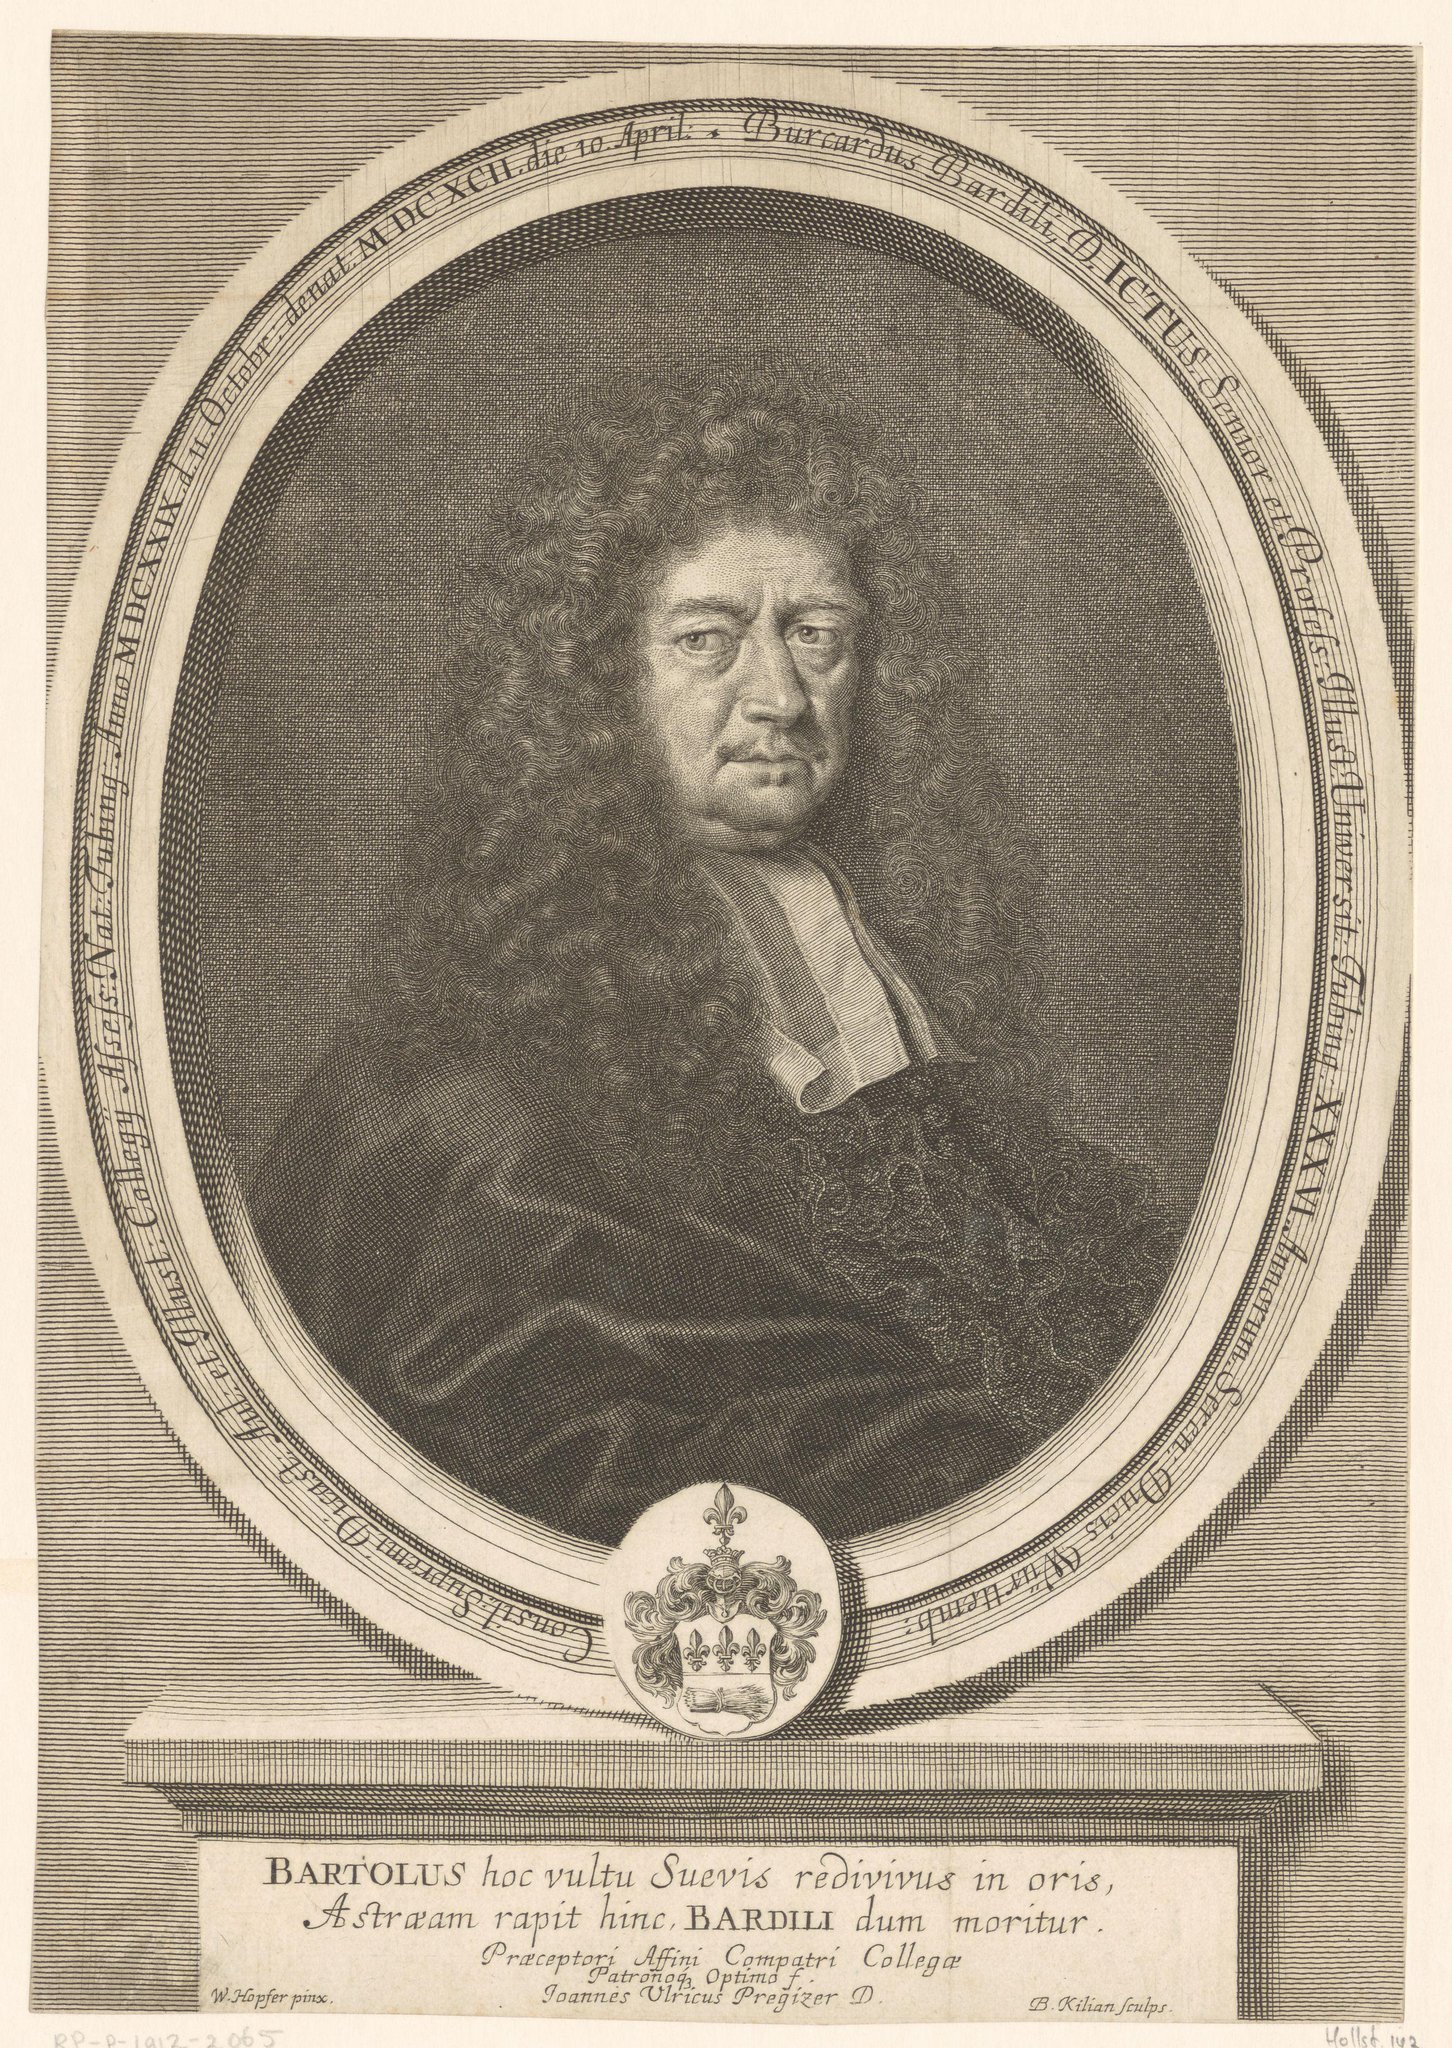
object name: print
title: Portret van Burckhard Bardili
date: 1692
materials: paper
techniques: engraving, etching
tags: further education (+ portrait of teacher, professor), historical persons, lawyer, attorney at law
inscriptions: collector's mark: Lugt 2228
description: Tekst in het Latijn in de omlijsting en in de marge onderaan.